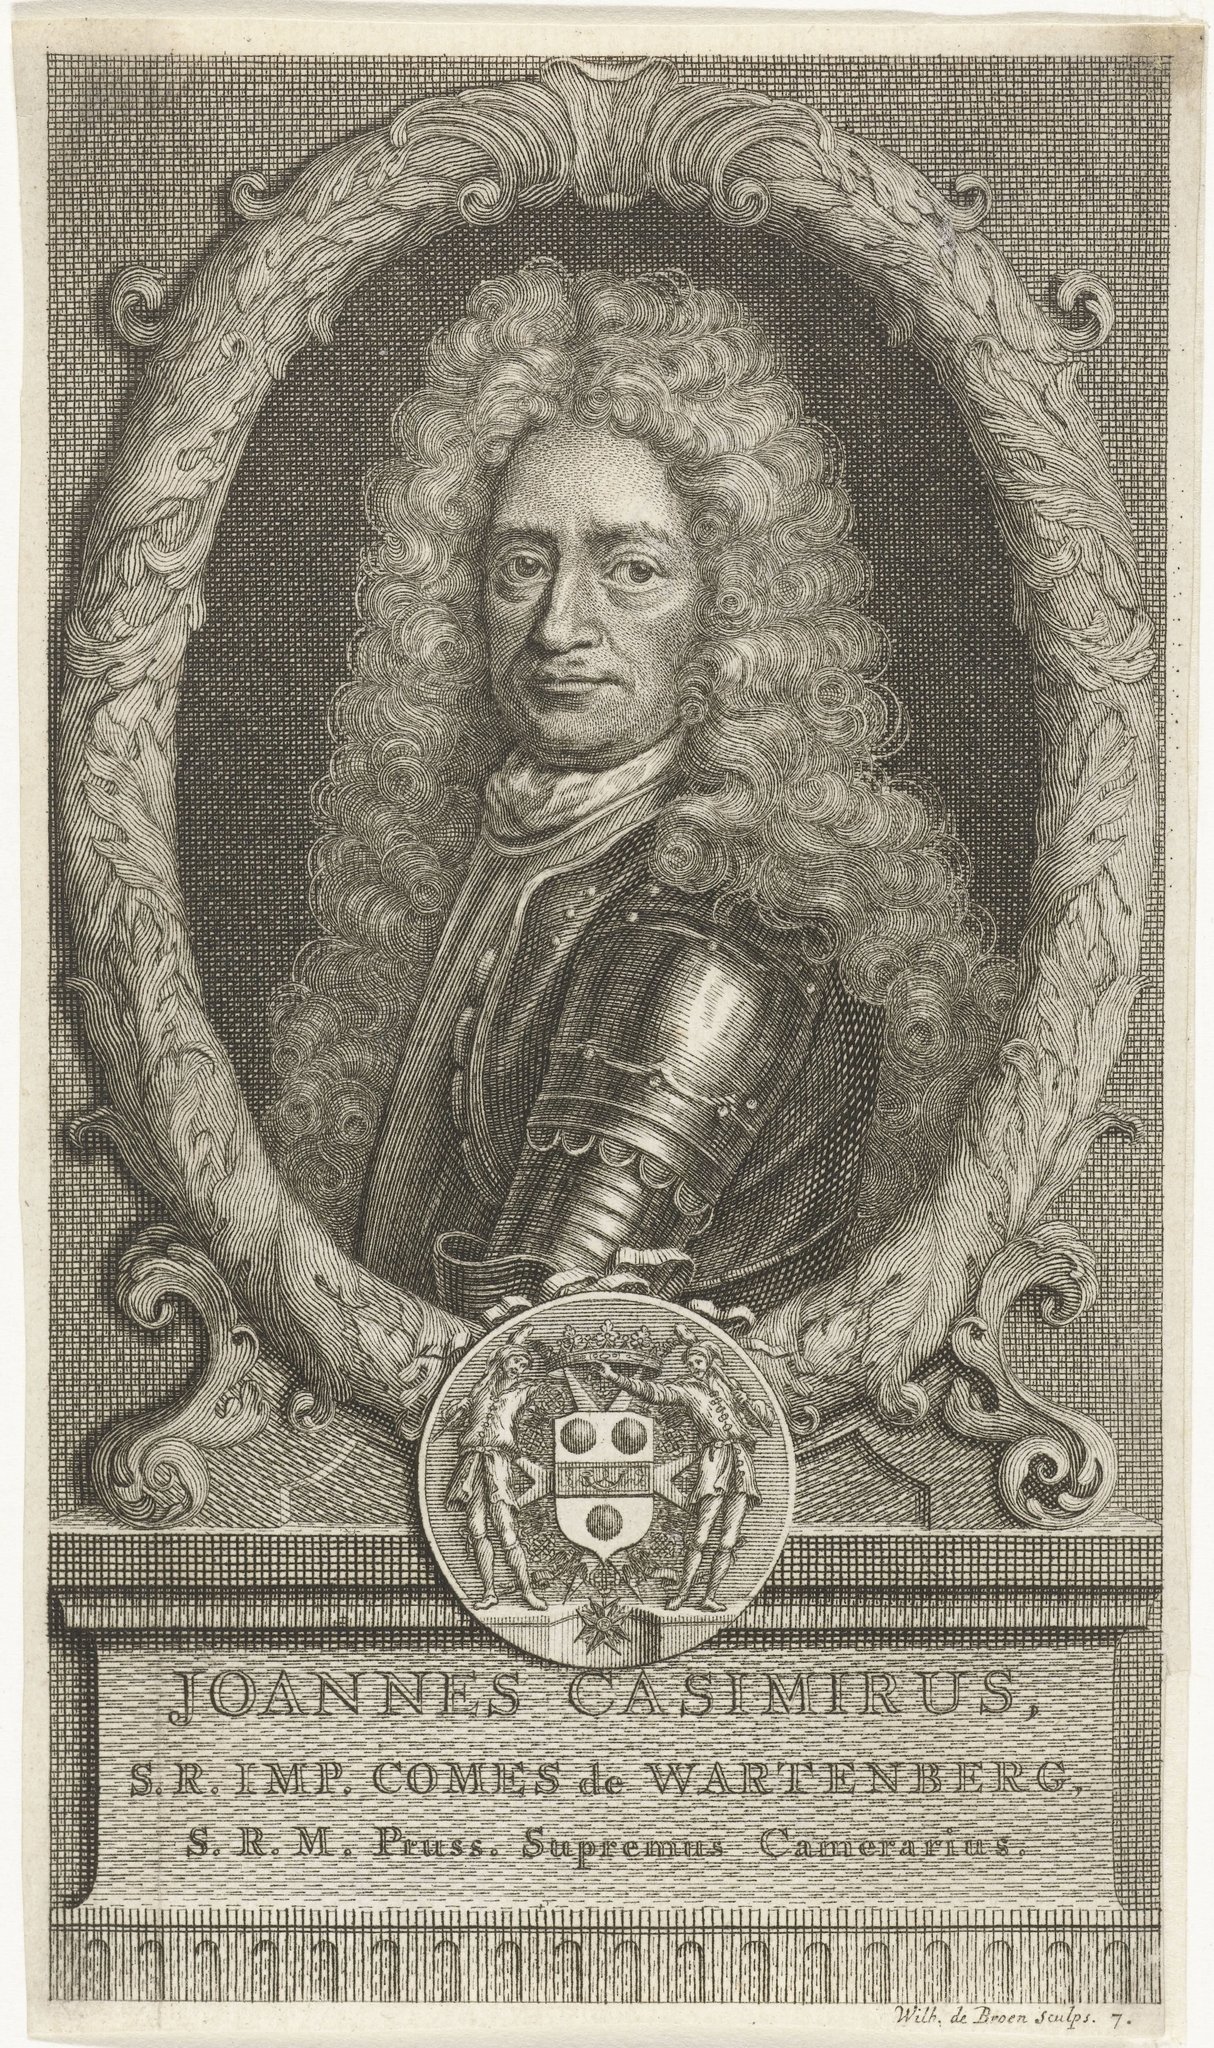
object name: print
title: Portret van Johann Casimir Kolbe von Wartenberg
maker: willem de broen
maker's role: print maker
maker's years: 1686-1748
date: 1705-1748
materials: paper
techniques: engraving, etching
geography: amsterdam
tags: hessen, frankfurt, staatsman, johann casimir kolbe von wartenberg (ii)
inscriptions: collector's mark: Lugt 2228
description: Borstbeeld van Johannes Casimir van Wartenberg, eerste minister van Pruissen, in ovaal met familiewapen. Onder het portret zijn naam en titels.